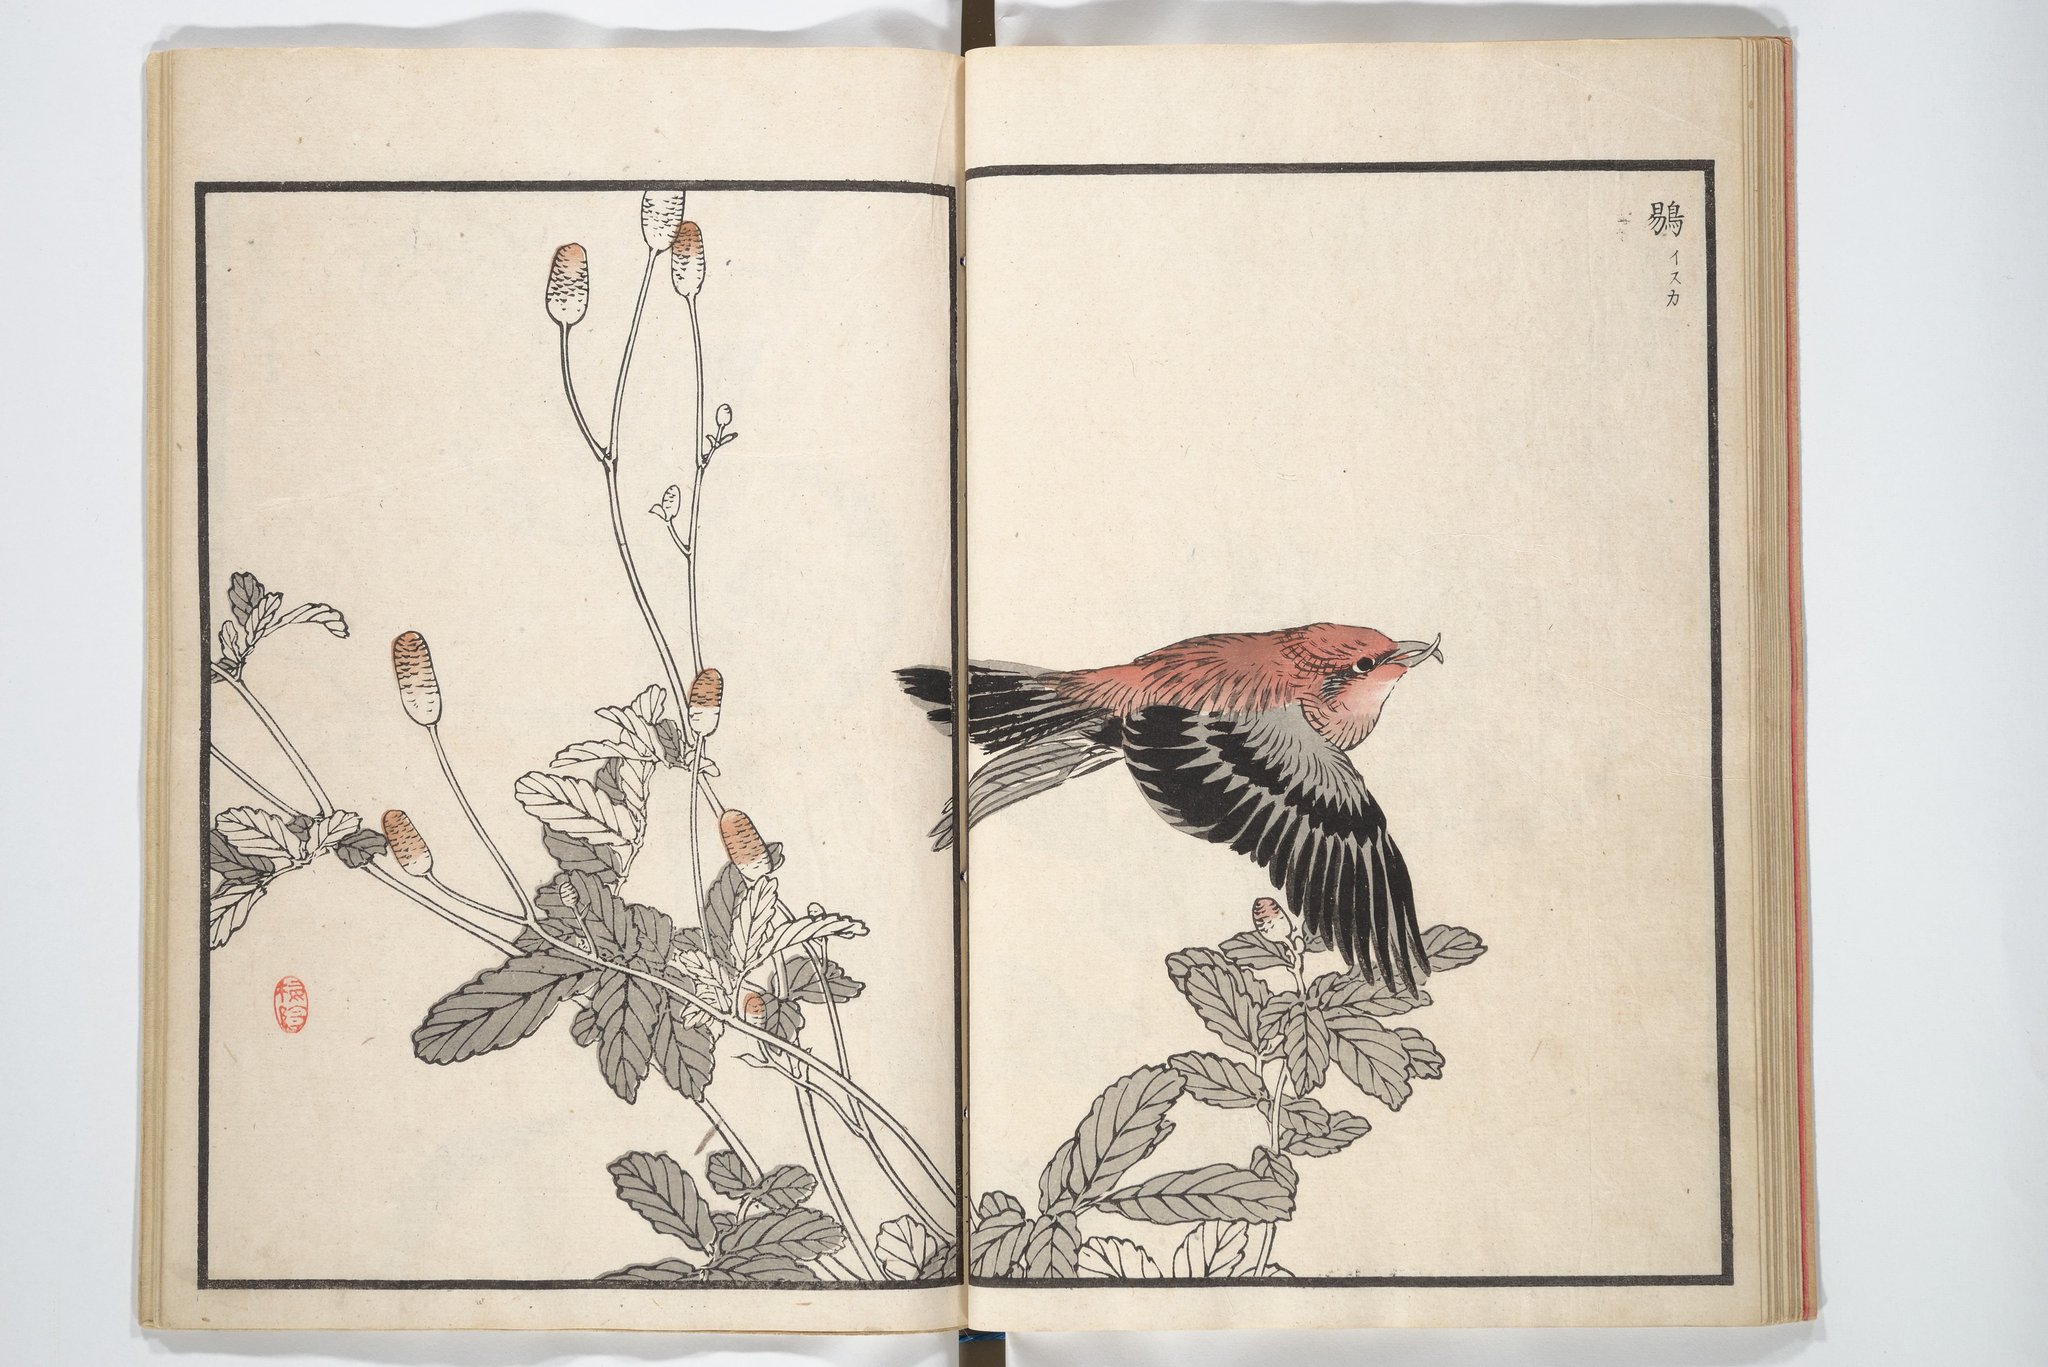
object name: illustrated book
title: Bairei Picture Album of One Hundred Birds (Bairei hyakuchō gafu) 楳嶺百鳥畫譜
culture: japanese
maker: kōno bairei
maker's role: artist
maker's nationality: japanese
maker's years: 1844-1895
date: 1881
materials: ink, paper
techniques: woodblock print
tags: birds,plants